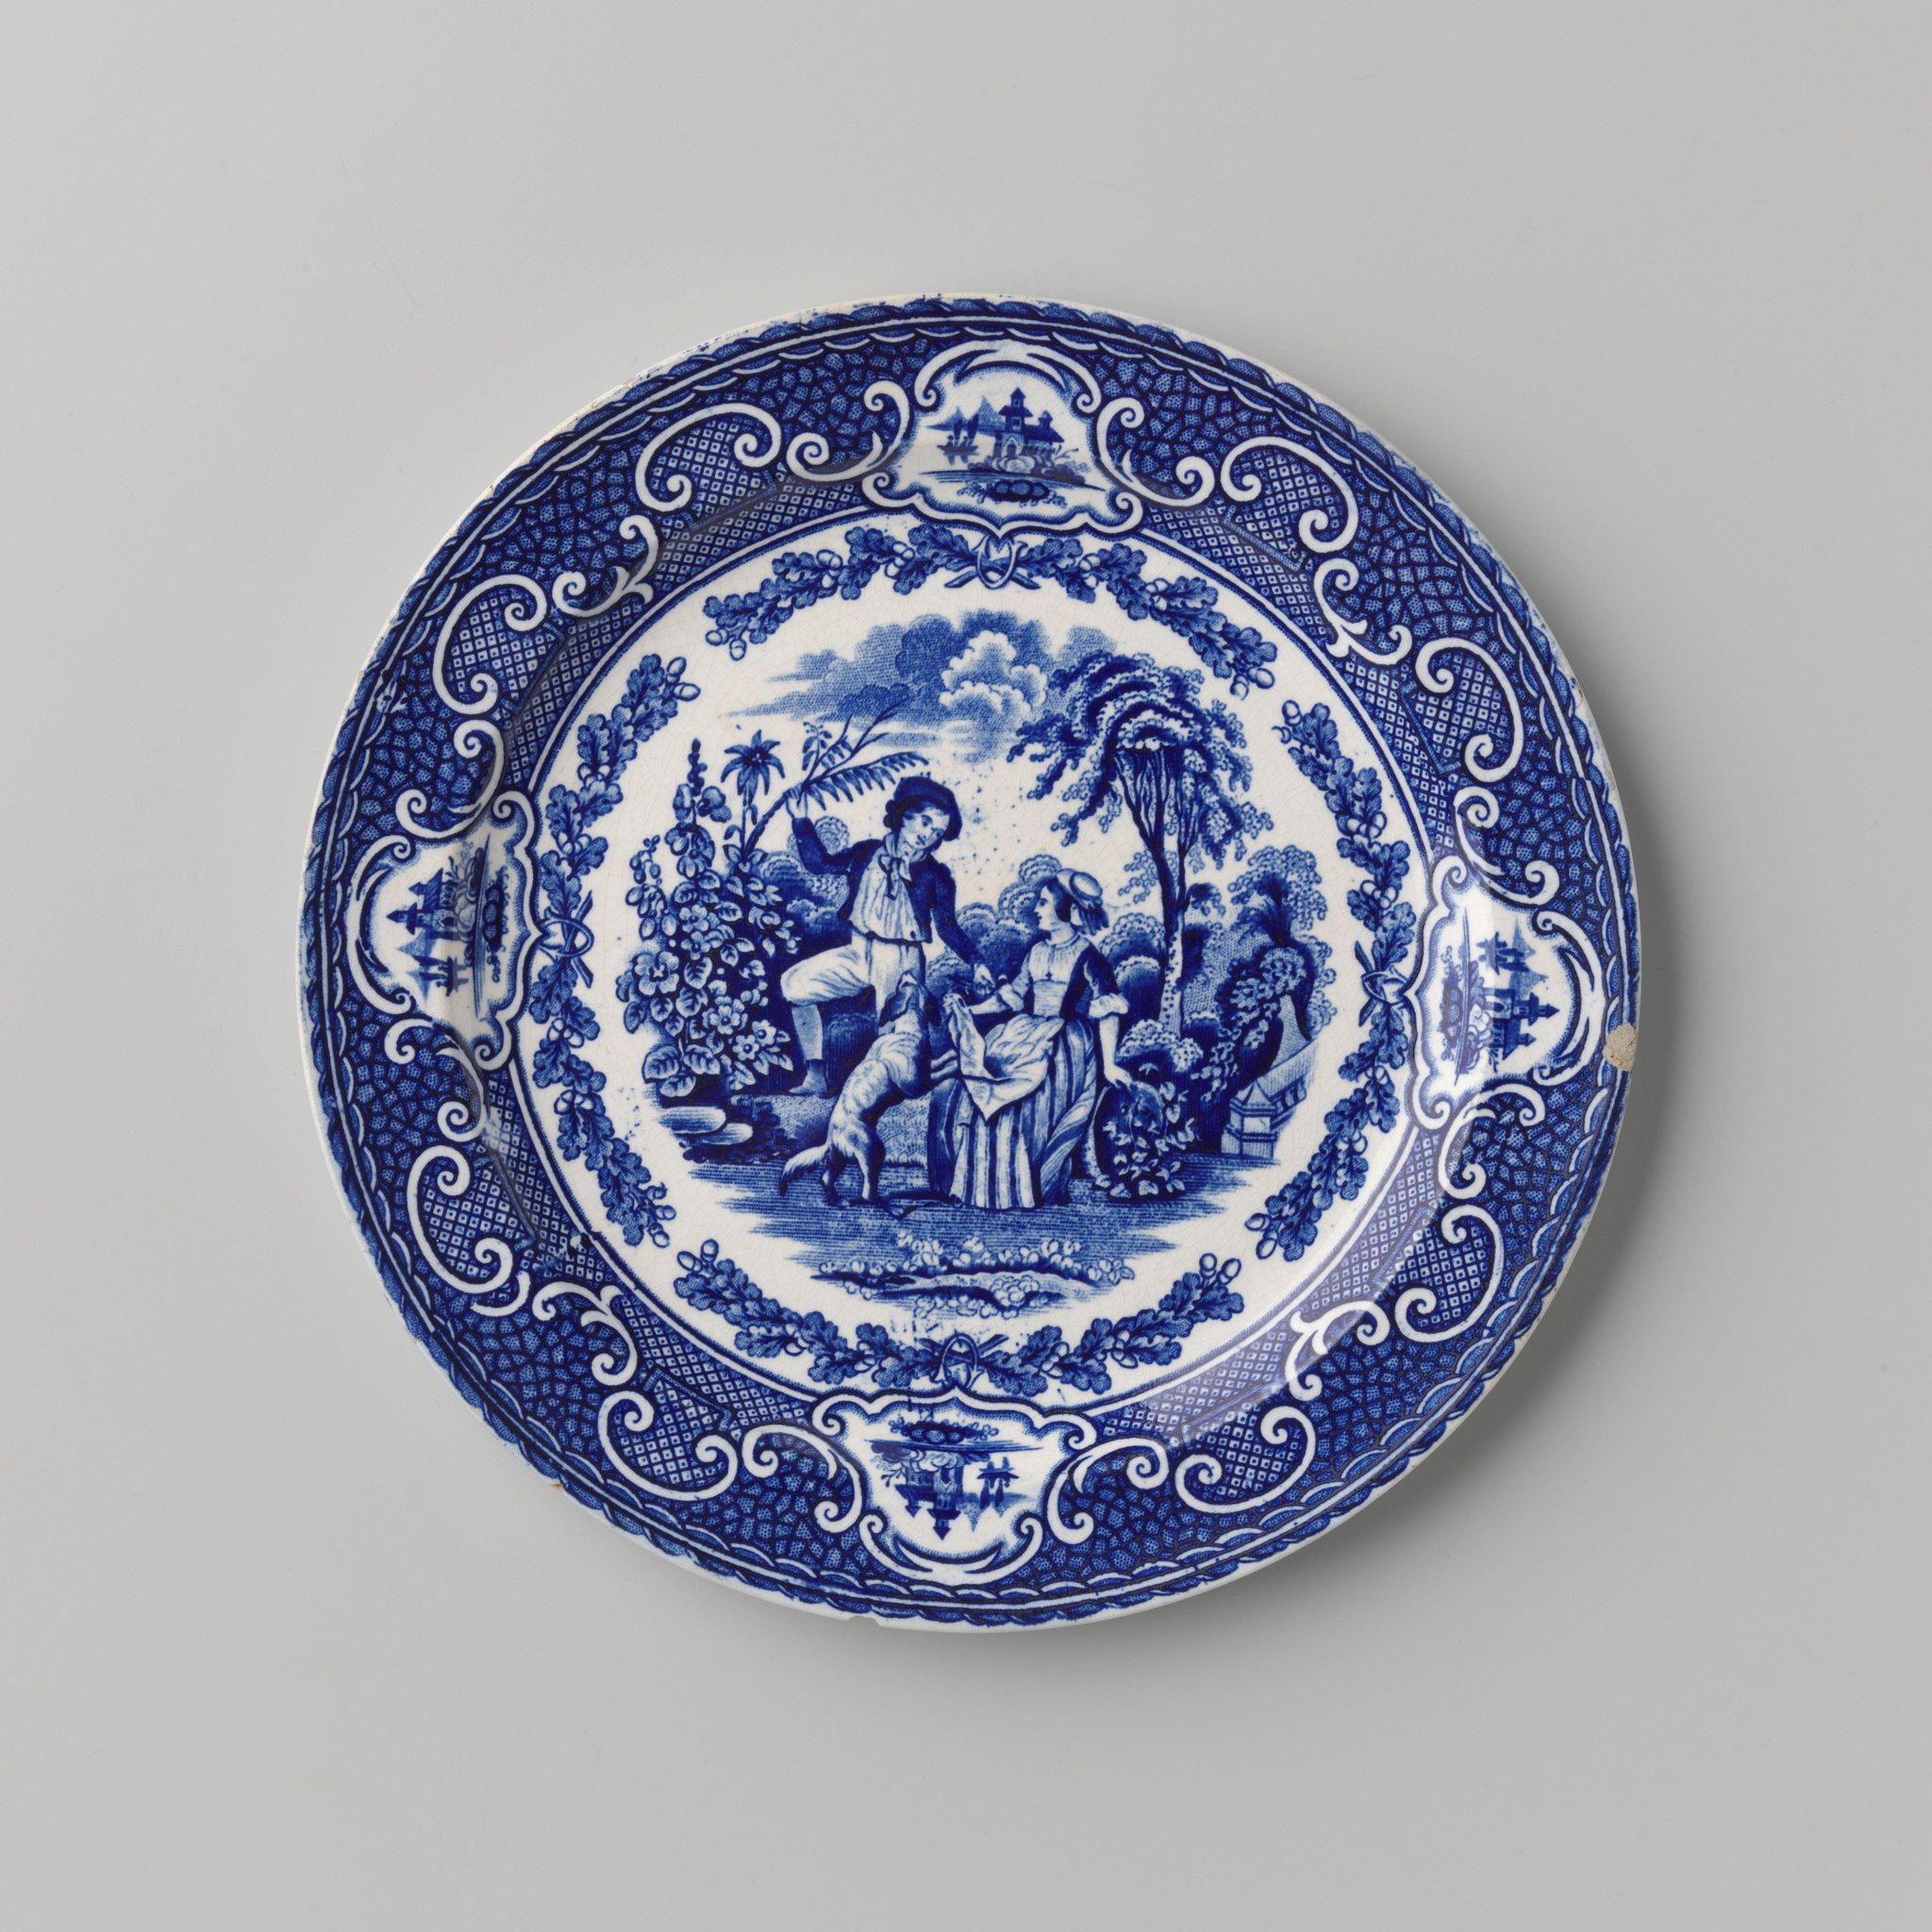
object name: plate dish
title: Bord, met op het plat een herder en een herderin in een tuin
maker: nicolaas antoine bosch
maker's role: ceramicist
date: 1853-1867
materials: creamware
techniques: transfer decoration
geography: maastricht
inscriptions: check stamp: ‘N. A. BOSCH // 8 // MAASTRICHT’, mark: ‘HERDERS // N. A. BOSCH en 2’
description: Bord van aardewerk met blauw transferdecor. Op het plat een herder en een herderin met hond in een tuin. Rond de voorstelling een band van eikentakken. De rand met vier cartouches met gebouwen. Tussen de cartouches c-voluten en geometrische motieven.